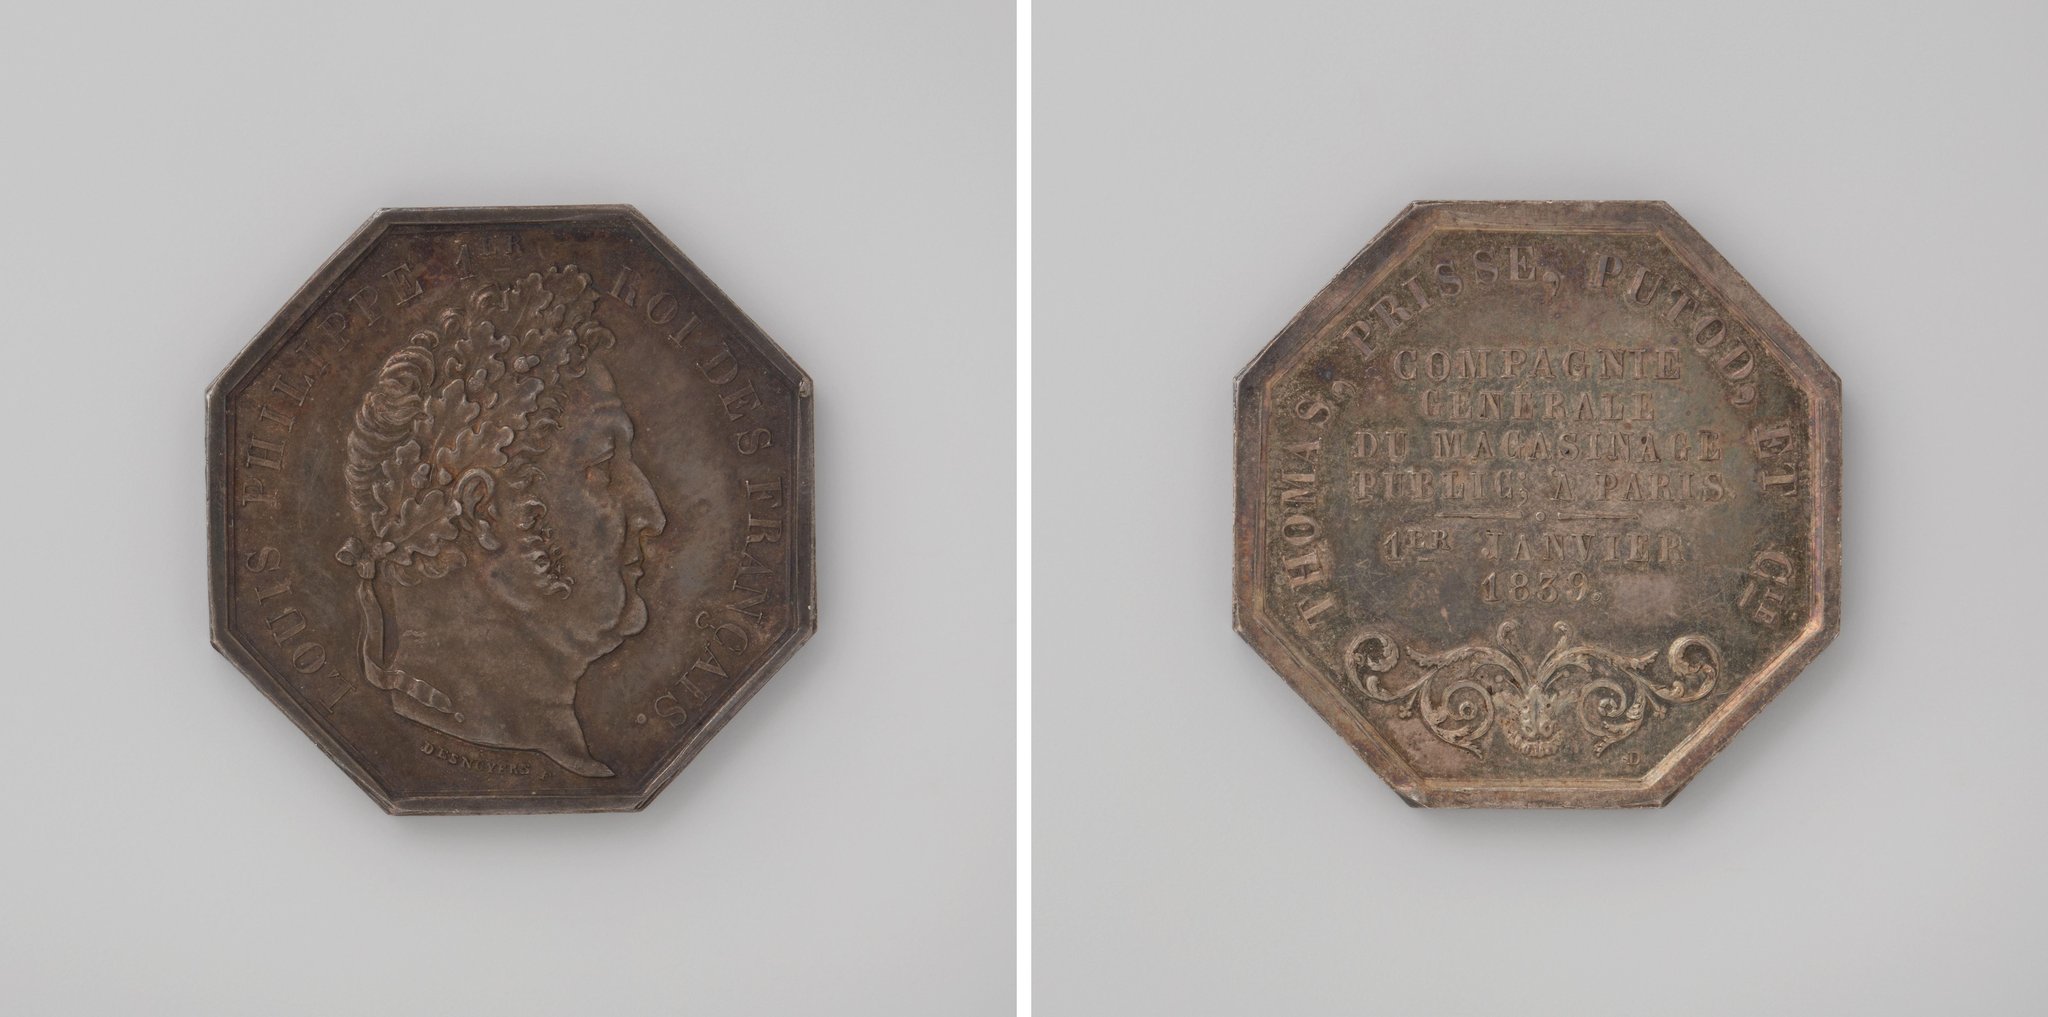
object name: new year medal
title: Compagnie Generale du Magasinage Public te Parijs, ter ere van Lodewijk Filips, koning der Fransen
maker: pierre hubert desnoyers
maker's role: medailleur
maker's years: 1767-1839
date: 1839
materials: silver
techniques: striking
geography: paris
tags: paris, lodewijk filips i (koning van frankrijk)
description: Zilveren achthoekige penning. Voorzijde: borststuk man met eikekrans binnen omschrift. Keerzijde: opschrift boven siermotief binnen omschrift.